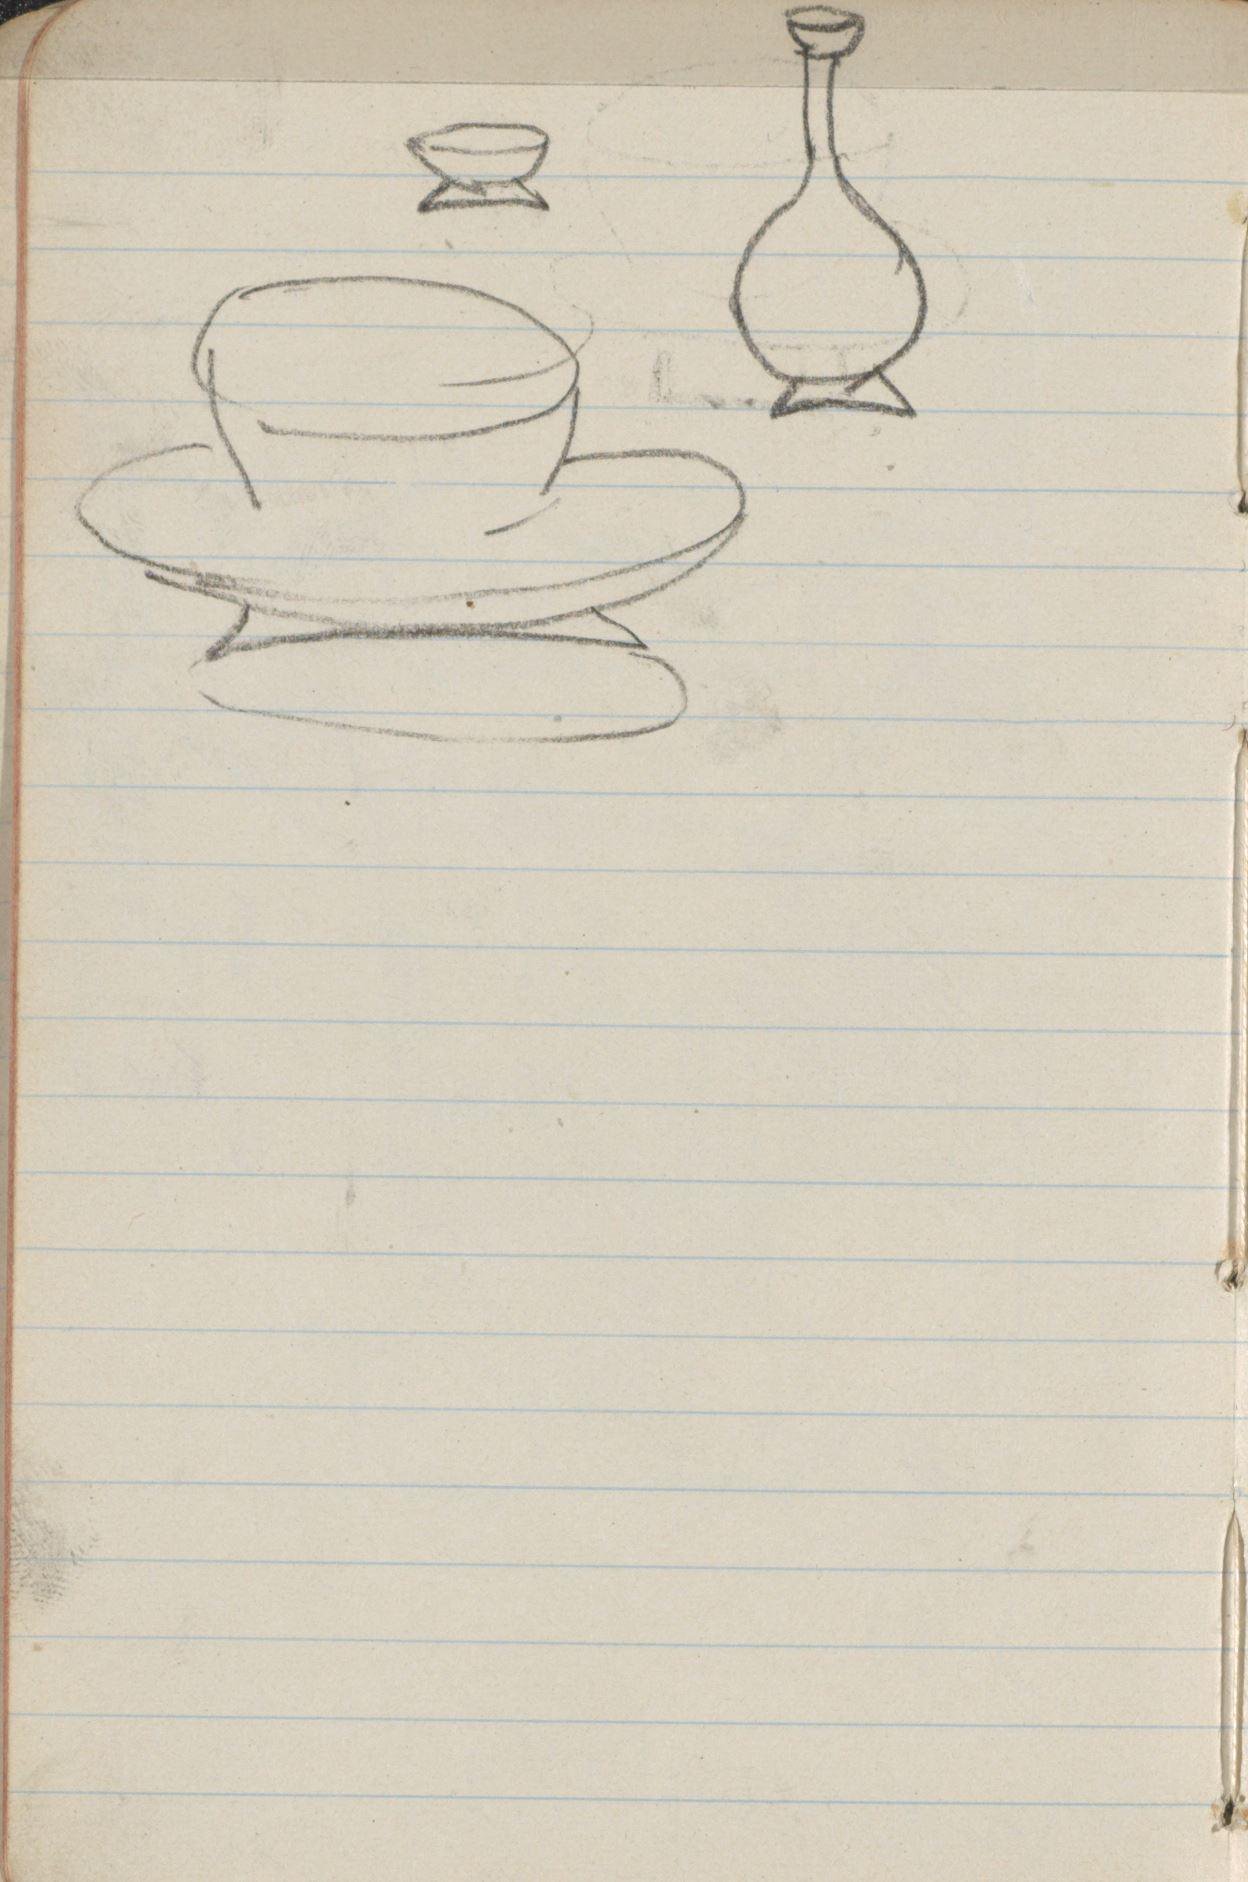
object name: sketchbook leaf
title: Voorwerpen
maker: george hendrik breitner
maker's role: draughtsman, painter, print maker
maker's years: 1857-1923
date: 1893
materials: chalk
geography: amsterdam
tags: container of glass: bottle, jar, vase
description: Pagina 39 uit een schetsboek met 38 bladen.